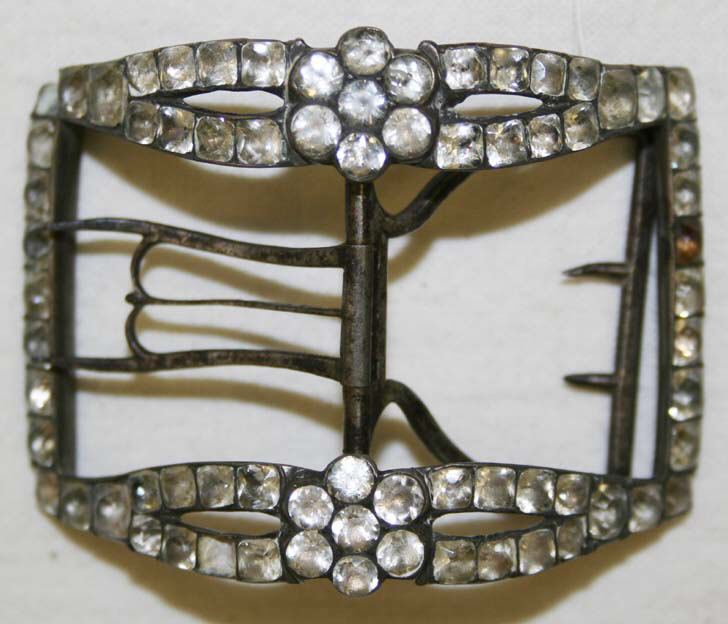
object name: shoe buckle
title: Shoe buckles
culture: british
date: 1767-1800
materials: metal, paste